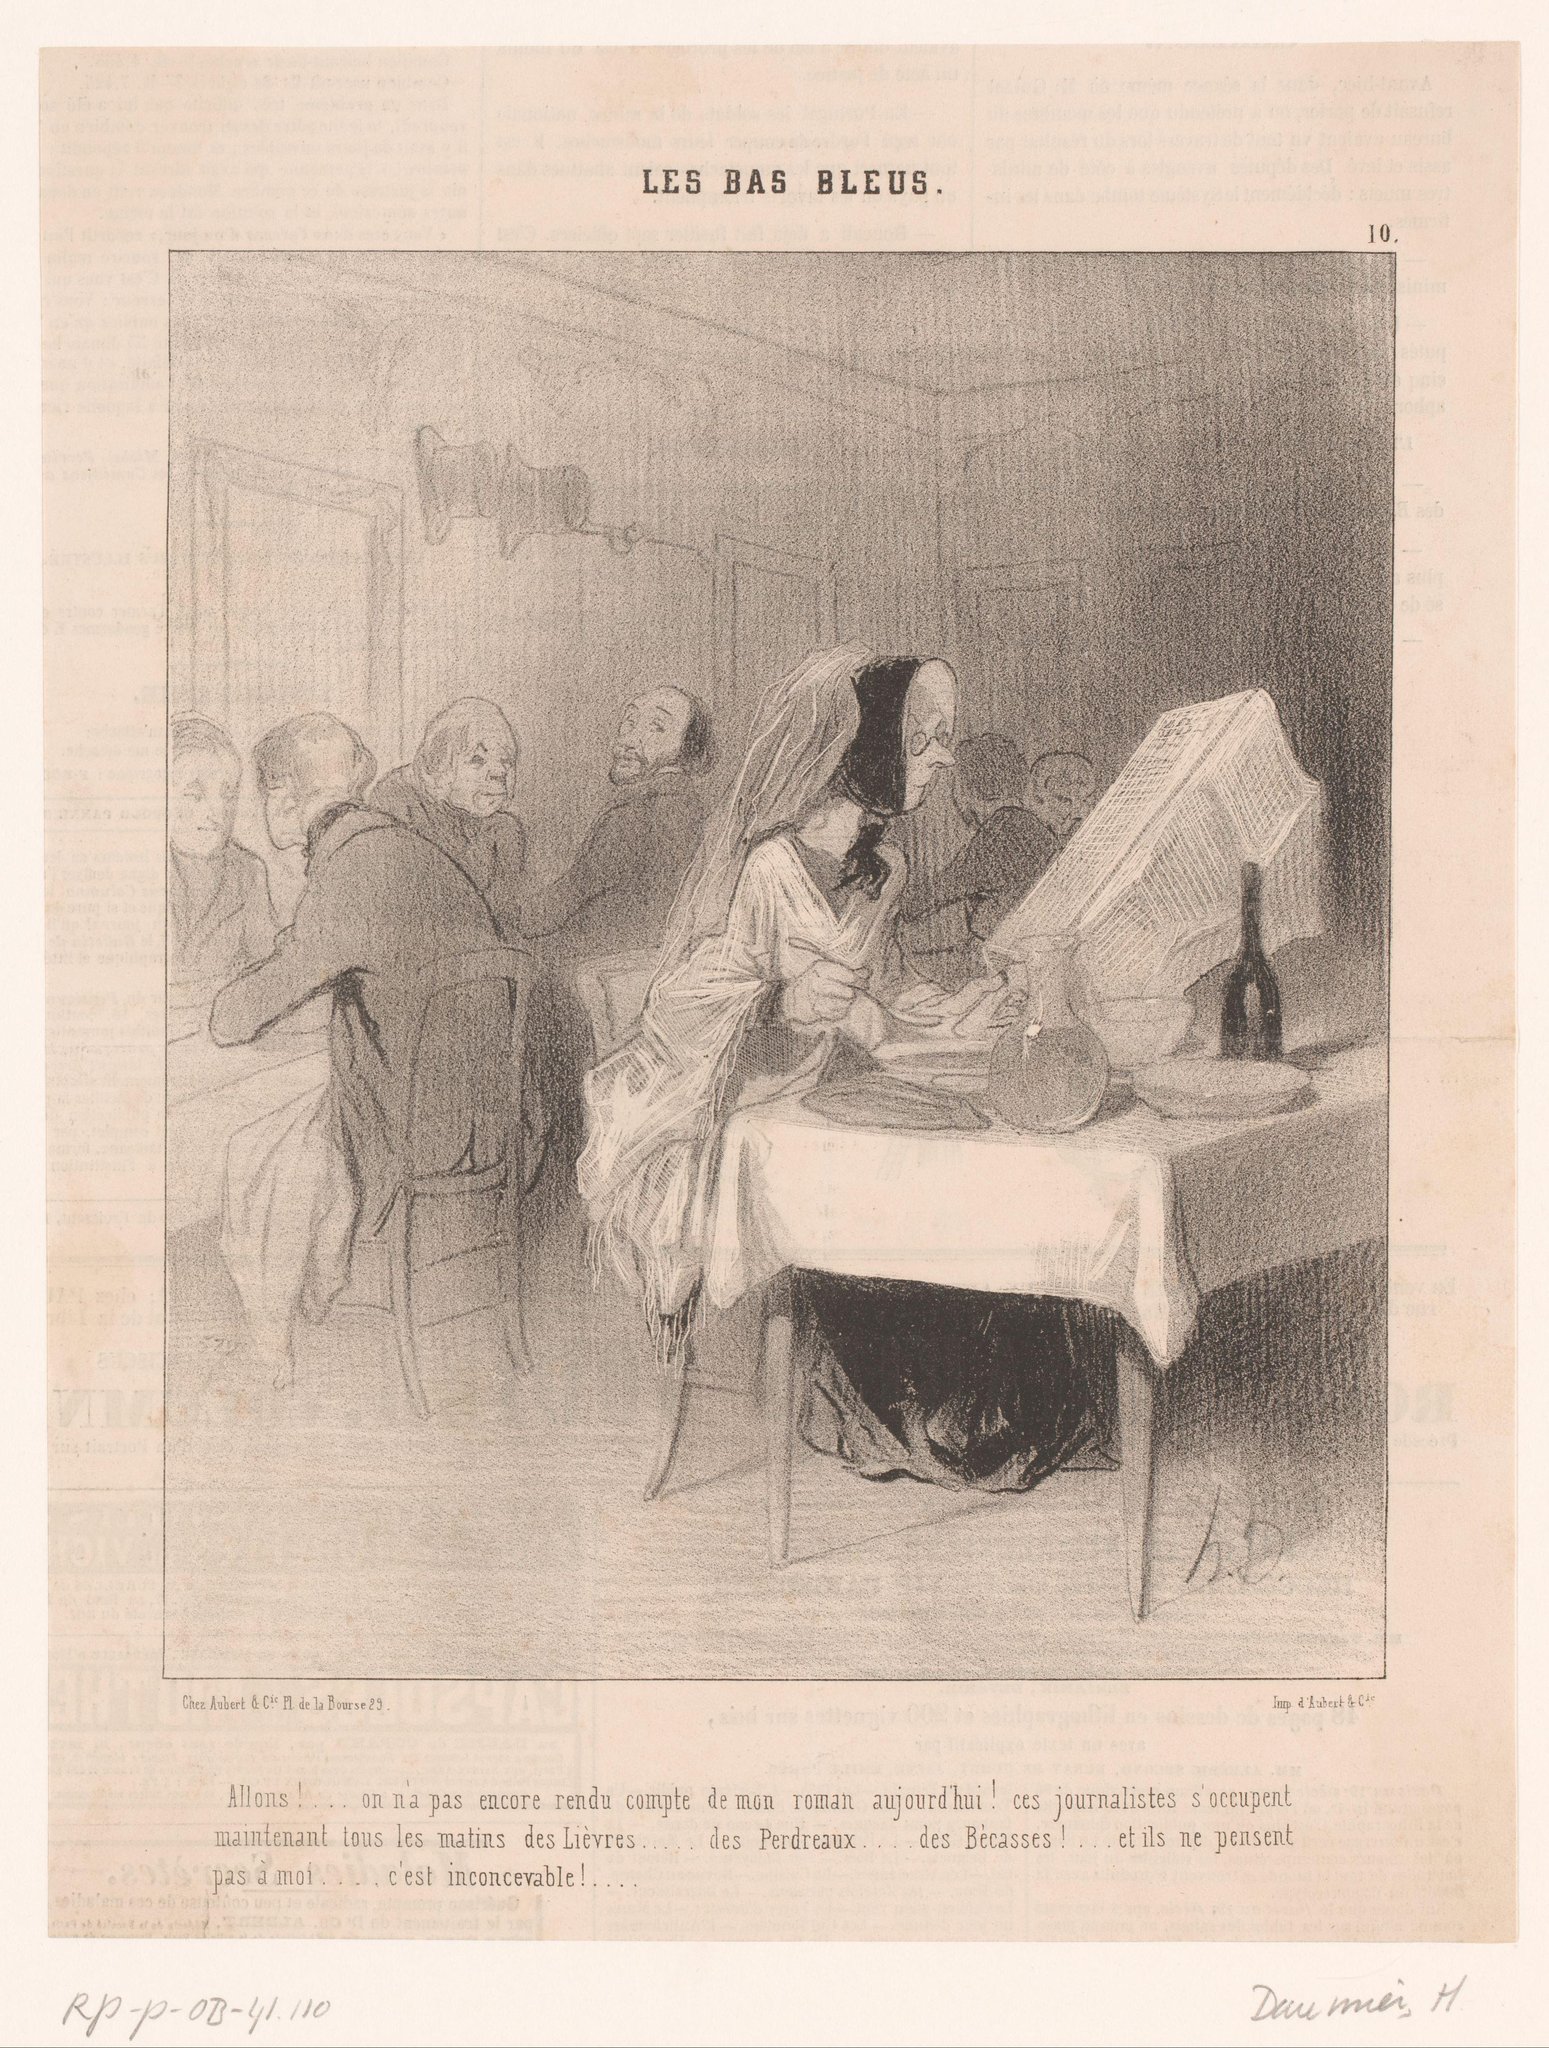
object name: print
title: Pedante vrouwen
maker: honoré daumier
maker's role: draughtsman, painter, print maker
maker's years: 1808-1879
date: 1844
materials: paper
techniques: lithograph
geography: paris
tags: caricatures (human types), writer, poet, author, restaurant, newspaper, news-sheet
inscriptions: collector's mark: Lugt 2228a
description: De schrijfster vindt het onbegrijpelijk dat haar boek niet is gerecenseerd in de krant.